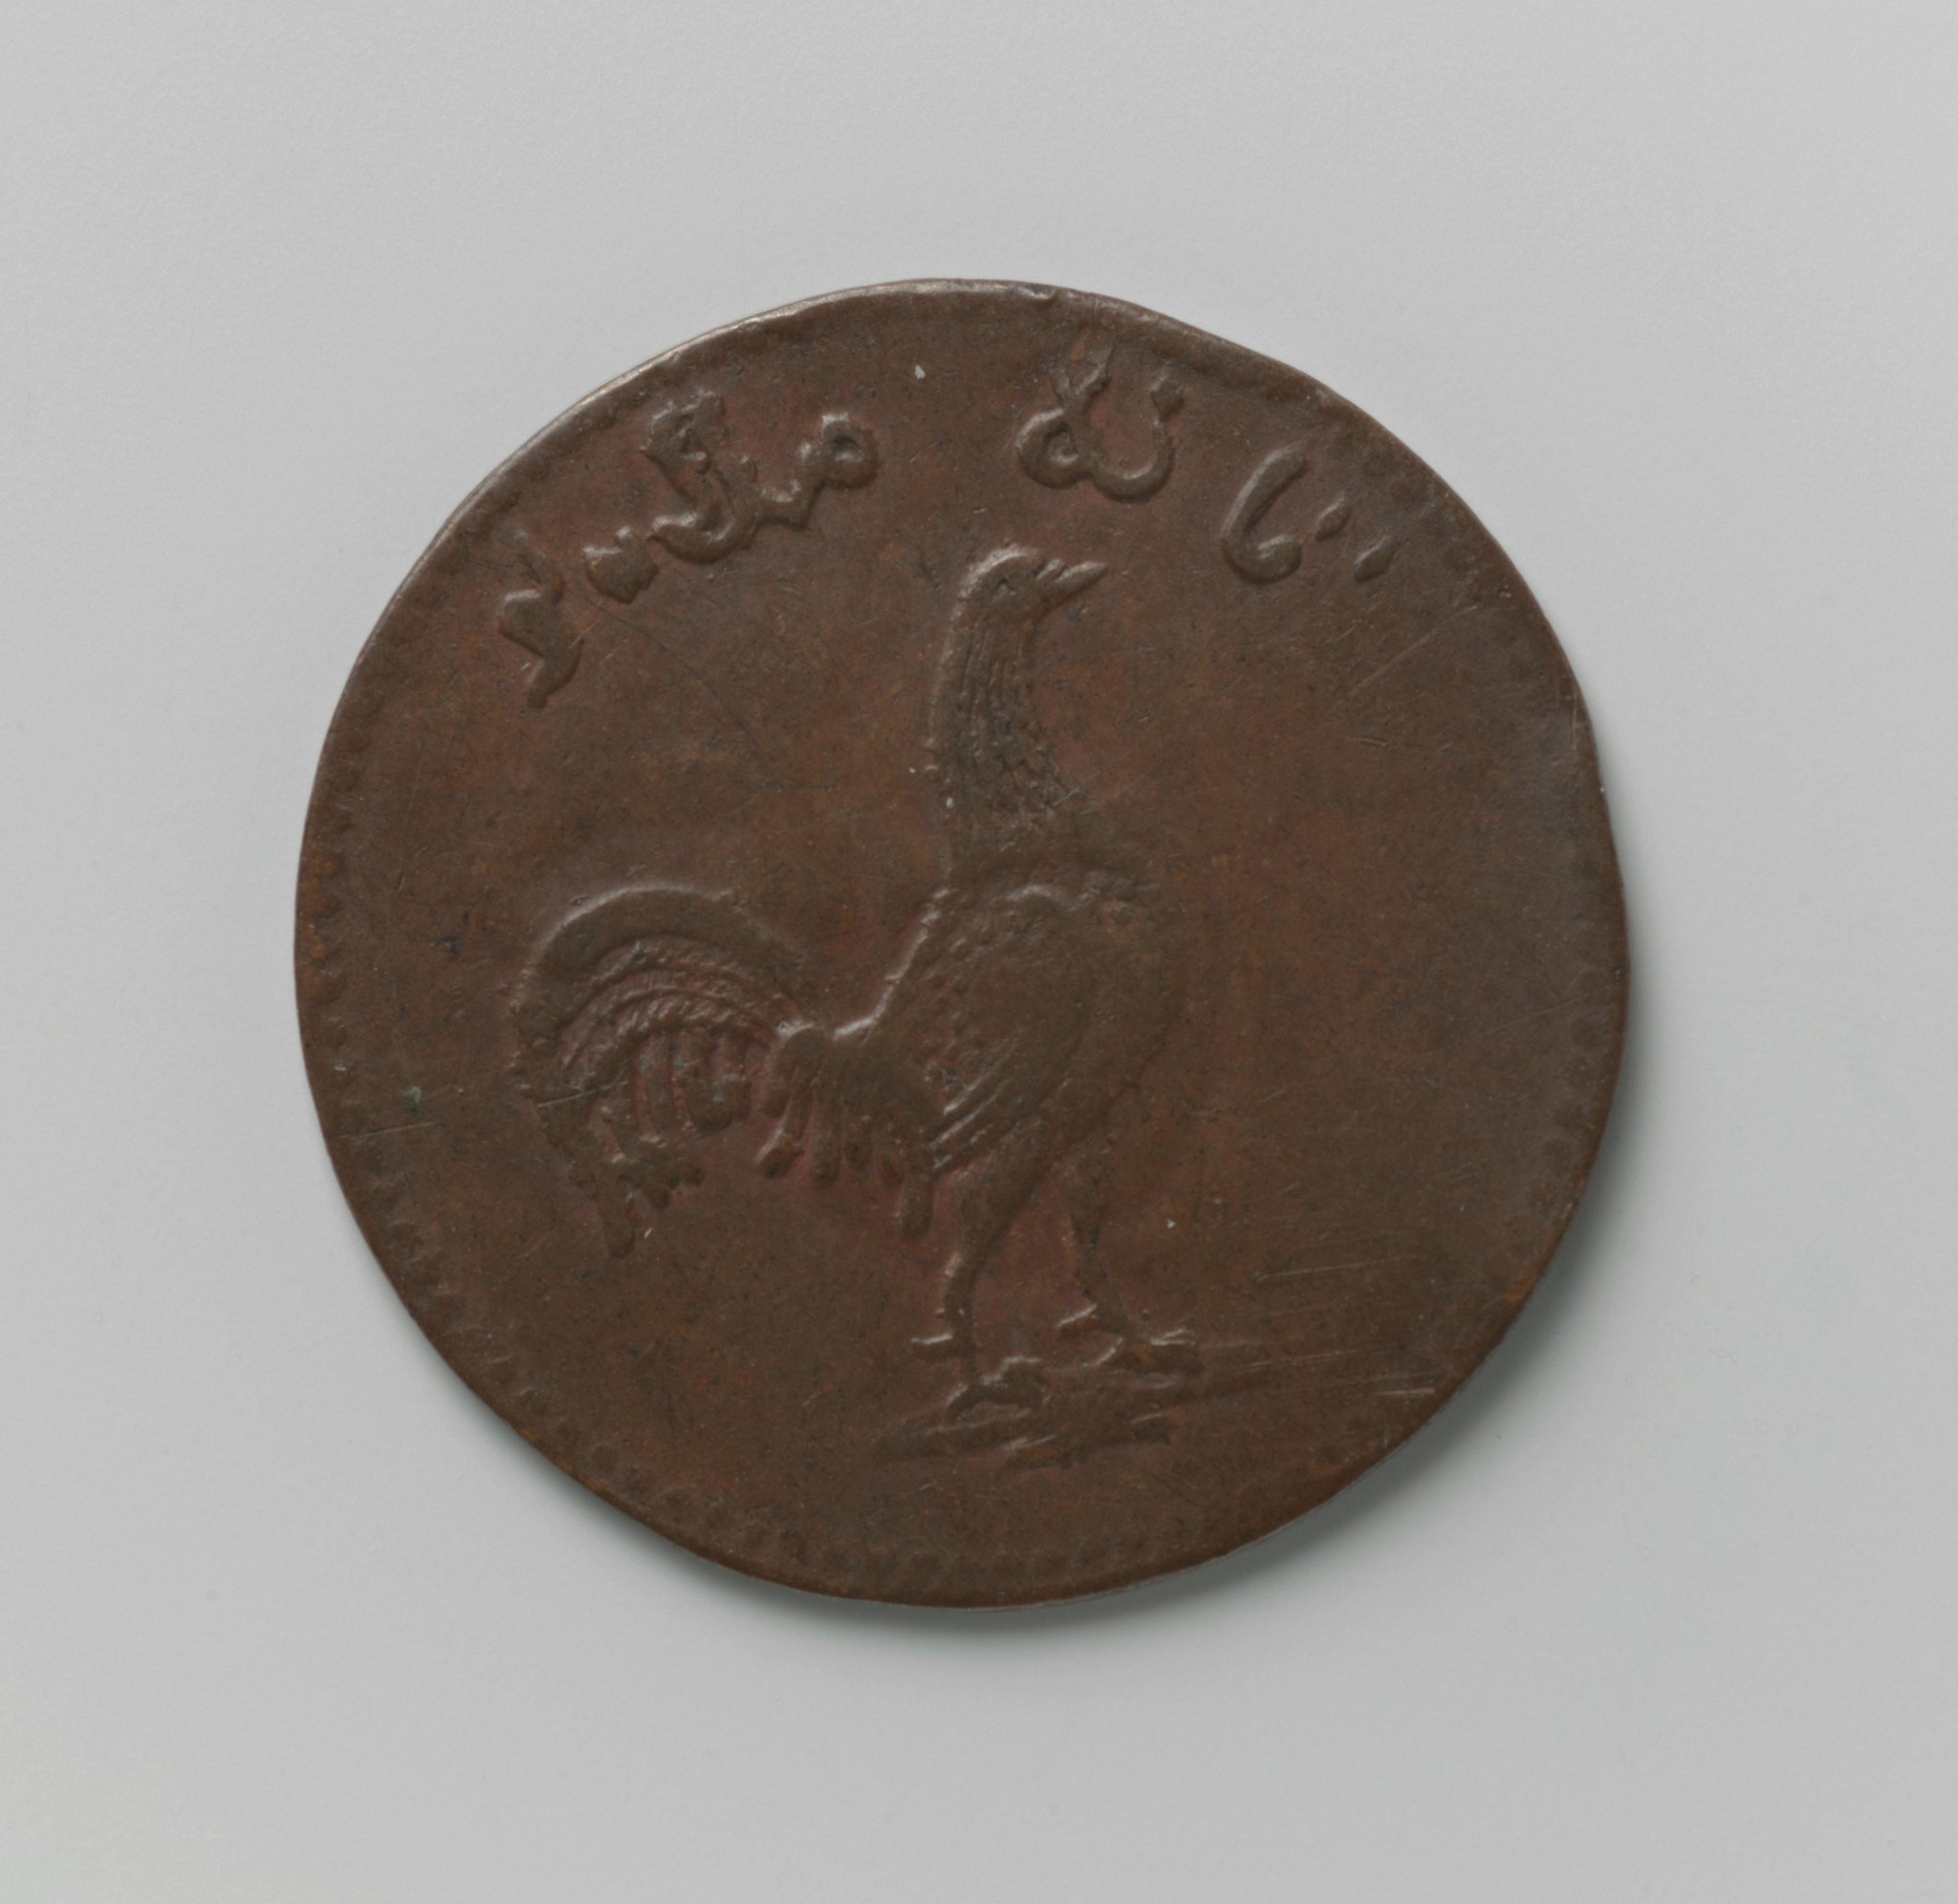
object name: coin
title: Malakka en Sumatra, haantjesduit, 1831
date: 1831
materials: copper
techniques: striking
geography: birmingham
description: Koperen munt. Particuliere munt. Voorzijde: haan naar rechts, waarboven aanduiding in het Maleis in Arabische lettertekens: Land van de Maleiers. Keerzijde: eenregelig Maleis opschrift in Arabische lettertekens, waarboven waarde-aanduiding 1 en waaronder het jaartal 1247 in Islamitische tijdsrekening. Gladde rand.